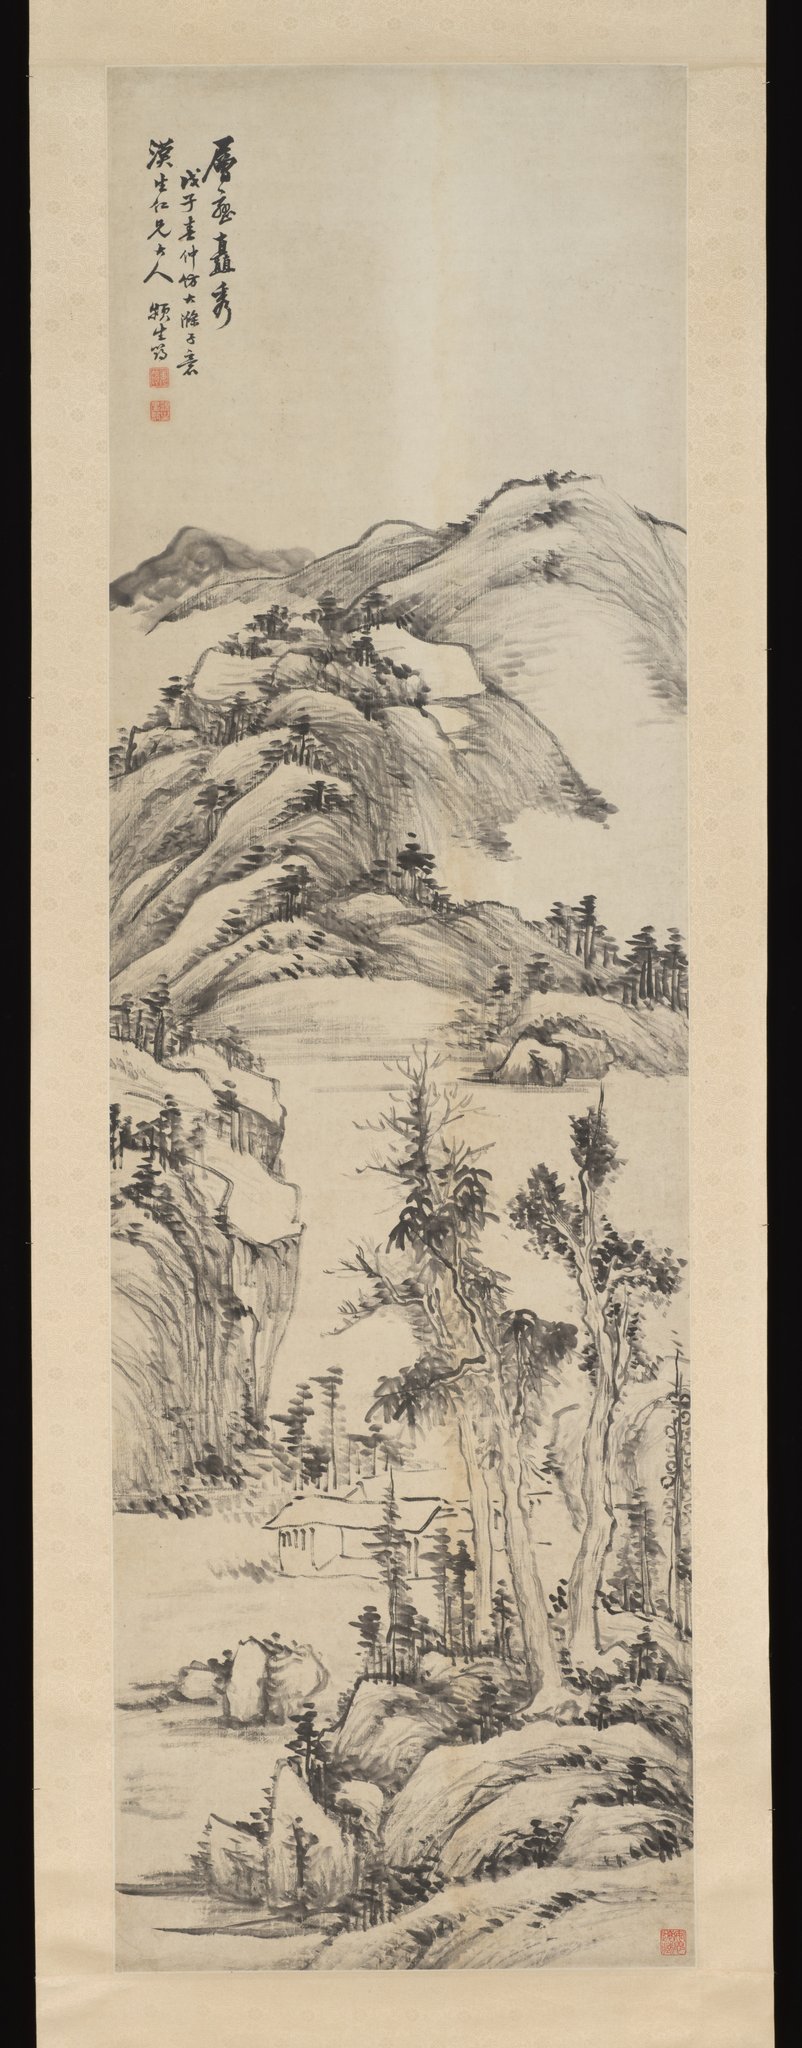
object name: hanging scroll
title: Landscape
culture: chinese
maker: jiang yun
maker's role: artist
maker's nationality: chinese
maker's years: 1847-1919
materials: ink, paper